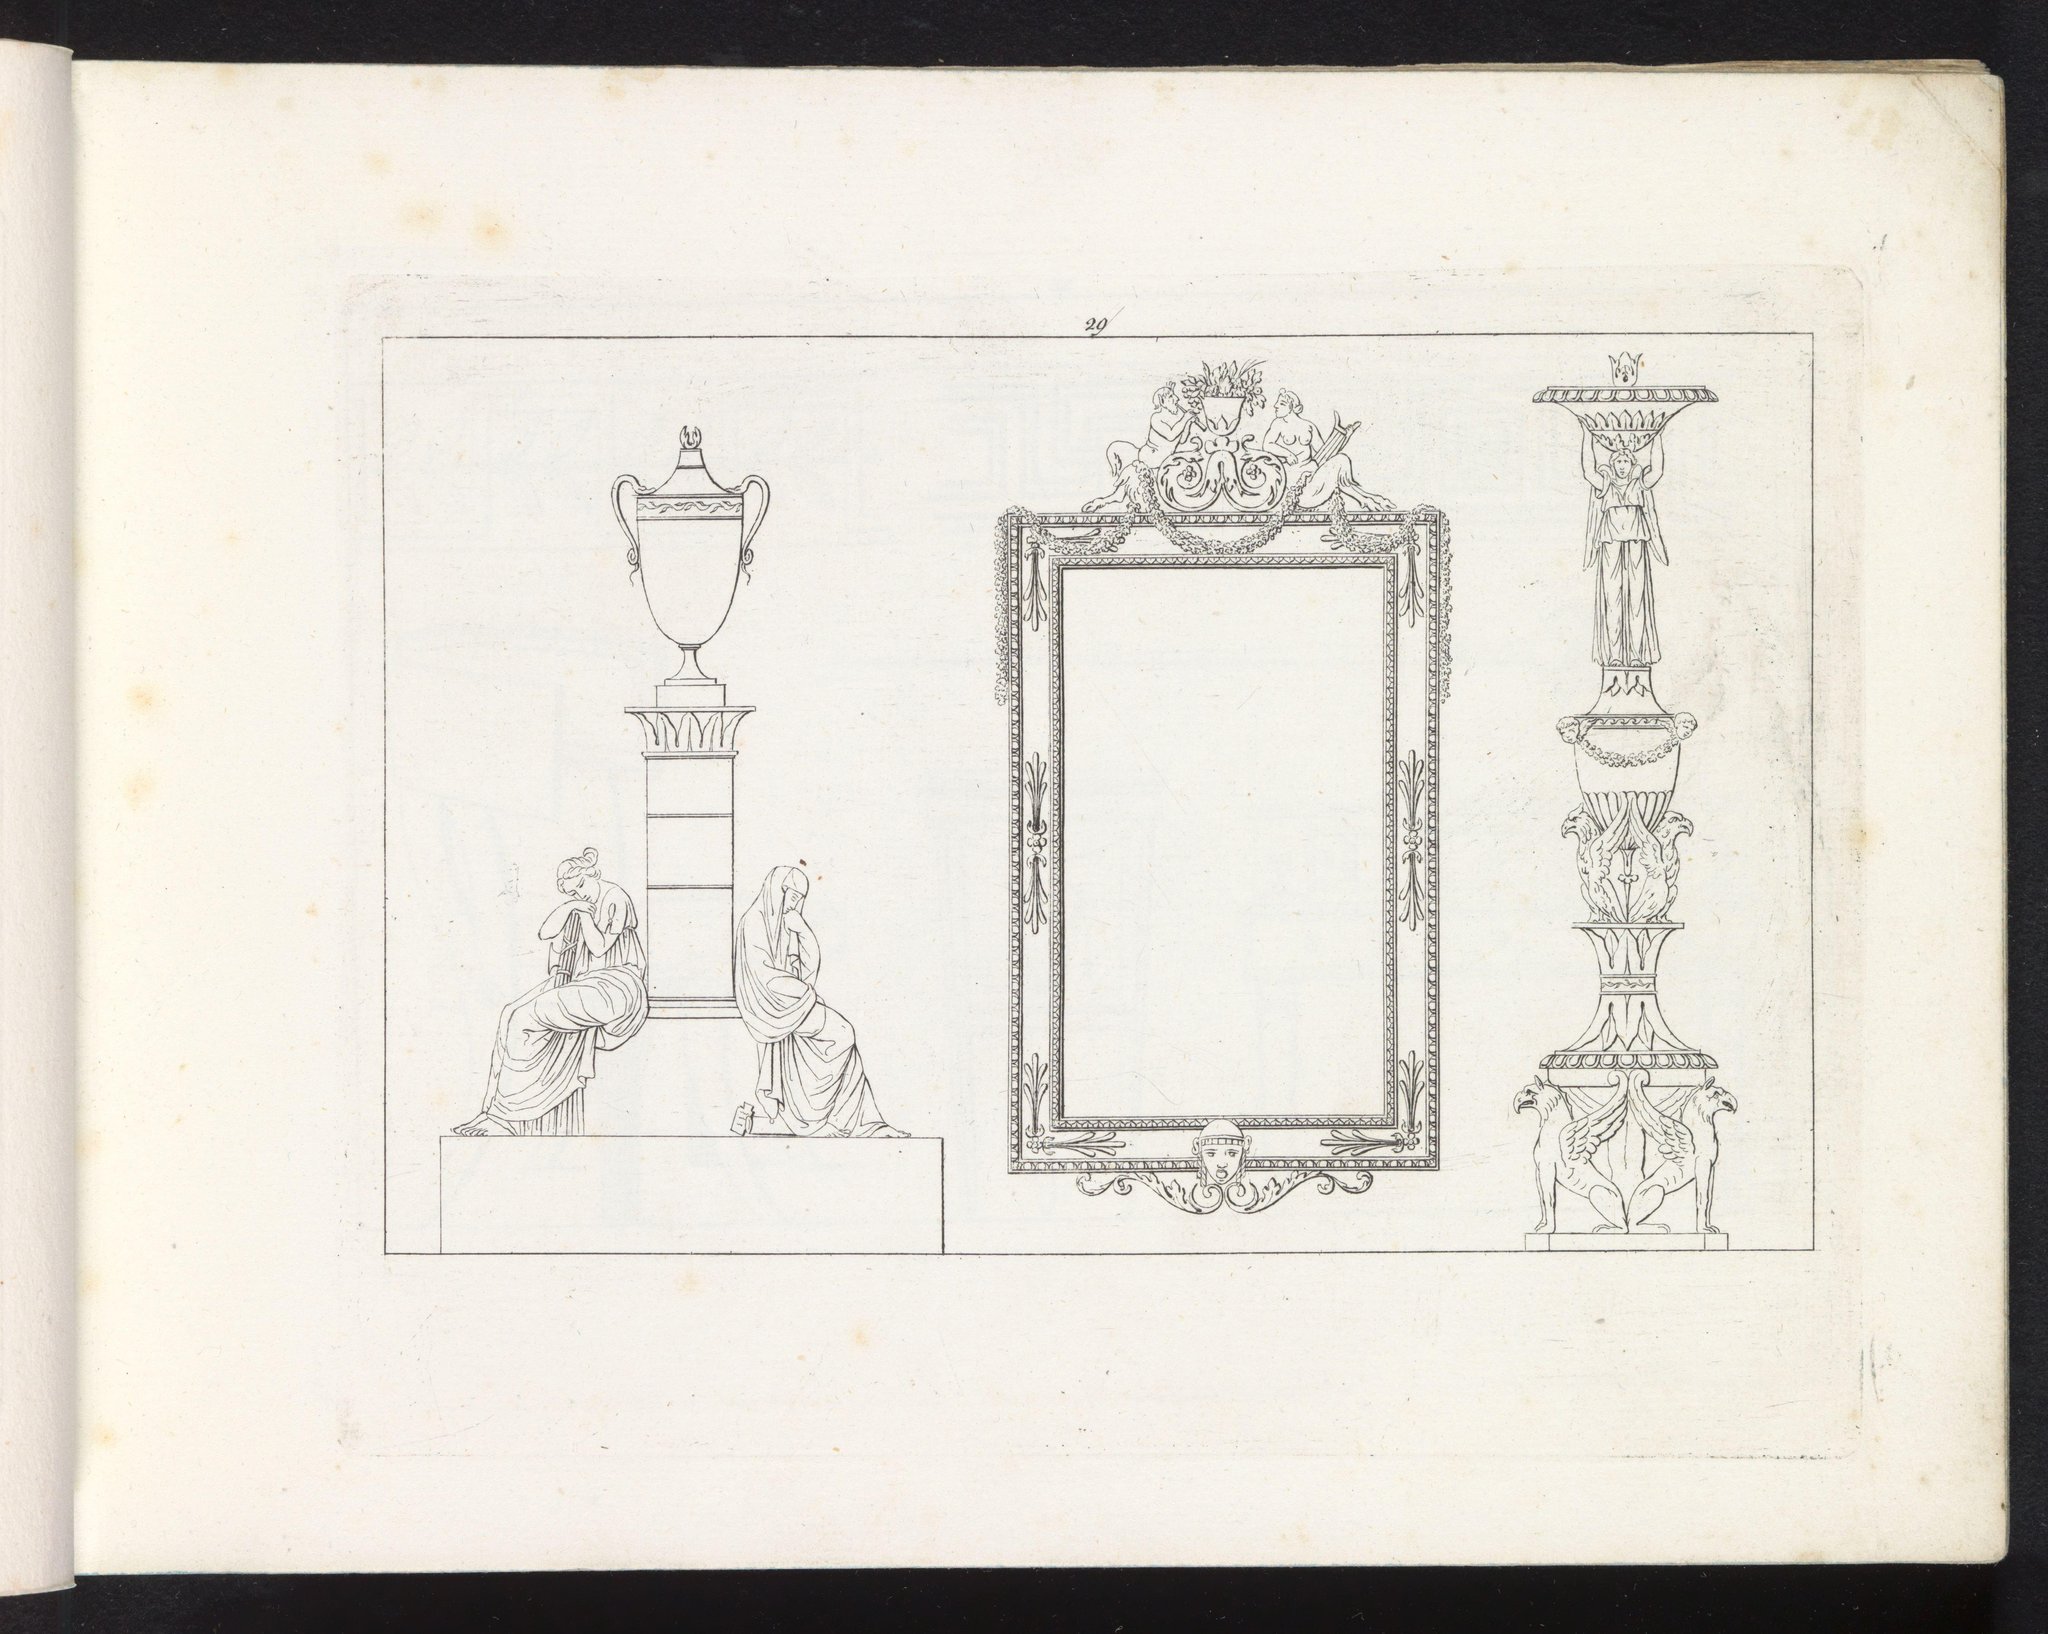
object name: ornament print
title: Invenzioni diverse di mobili ed utensili sacri e profani per usi comuni della vita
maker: pietro ruga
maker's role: print maker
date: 1817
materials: paper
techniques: etching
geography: italy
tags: ornaments ~ art, chandelier, candelabrum, urn, frame of painting, etc.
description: Prent maakt deel uit van een reeks van 100 prenten (+ titelprent) met ontwerpen voor religieuze en profane voorwerpen.